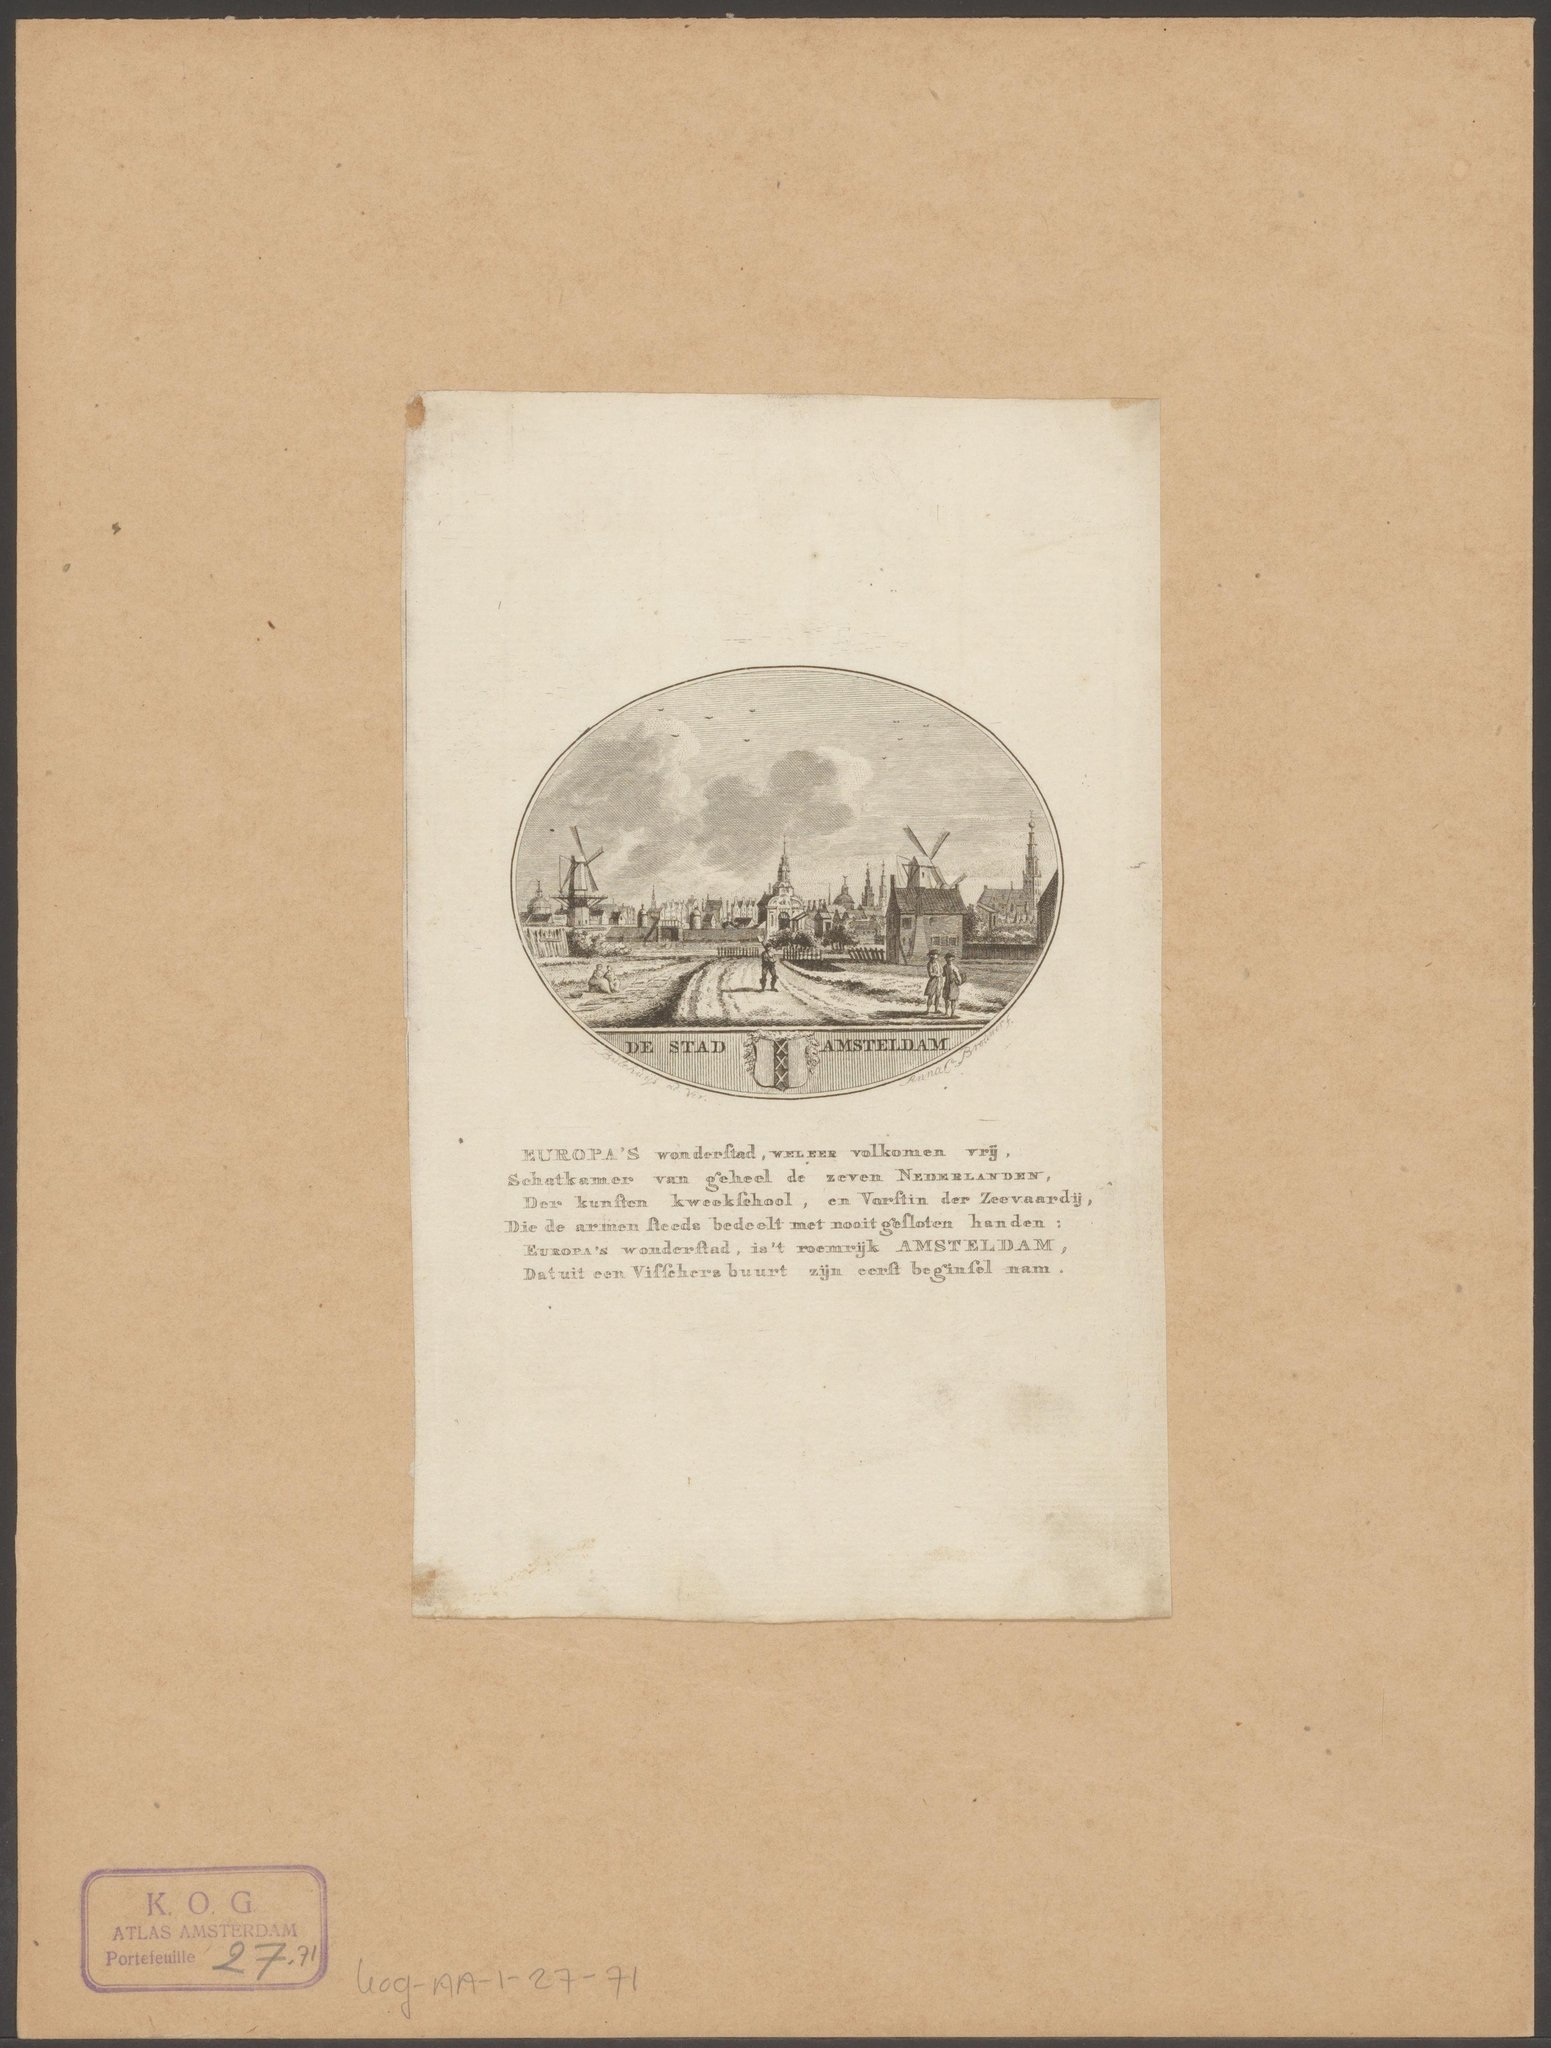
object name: print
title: Gezicht op de Haarlemmerpoort te Amsterdam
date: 1795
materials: paper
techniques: engraving, etching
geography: amsterdam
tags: rowing-boat, canoe, etc., bridge in city across river, canal, etc.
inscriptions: collector's mark: Lugt 1641b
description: Gezicht op de Haarlemmerpoort van buiten de stad. Daaronder het wapen van de stad. Onderaan een zesregelig vers. Onderwerpsrubriek binnen de Atlas Amsterdam: B. Poorten, verzamelbladen, D. Haarlemmerpoort(en).